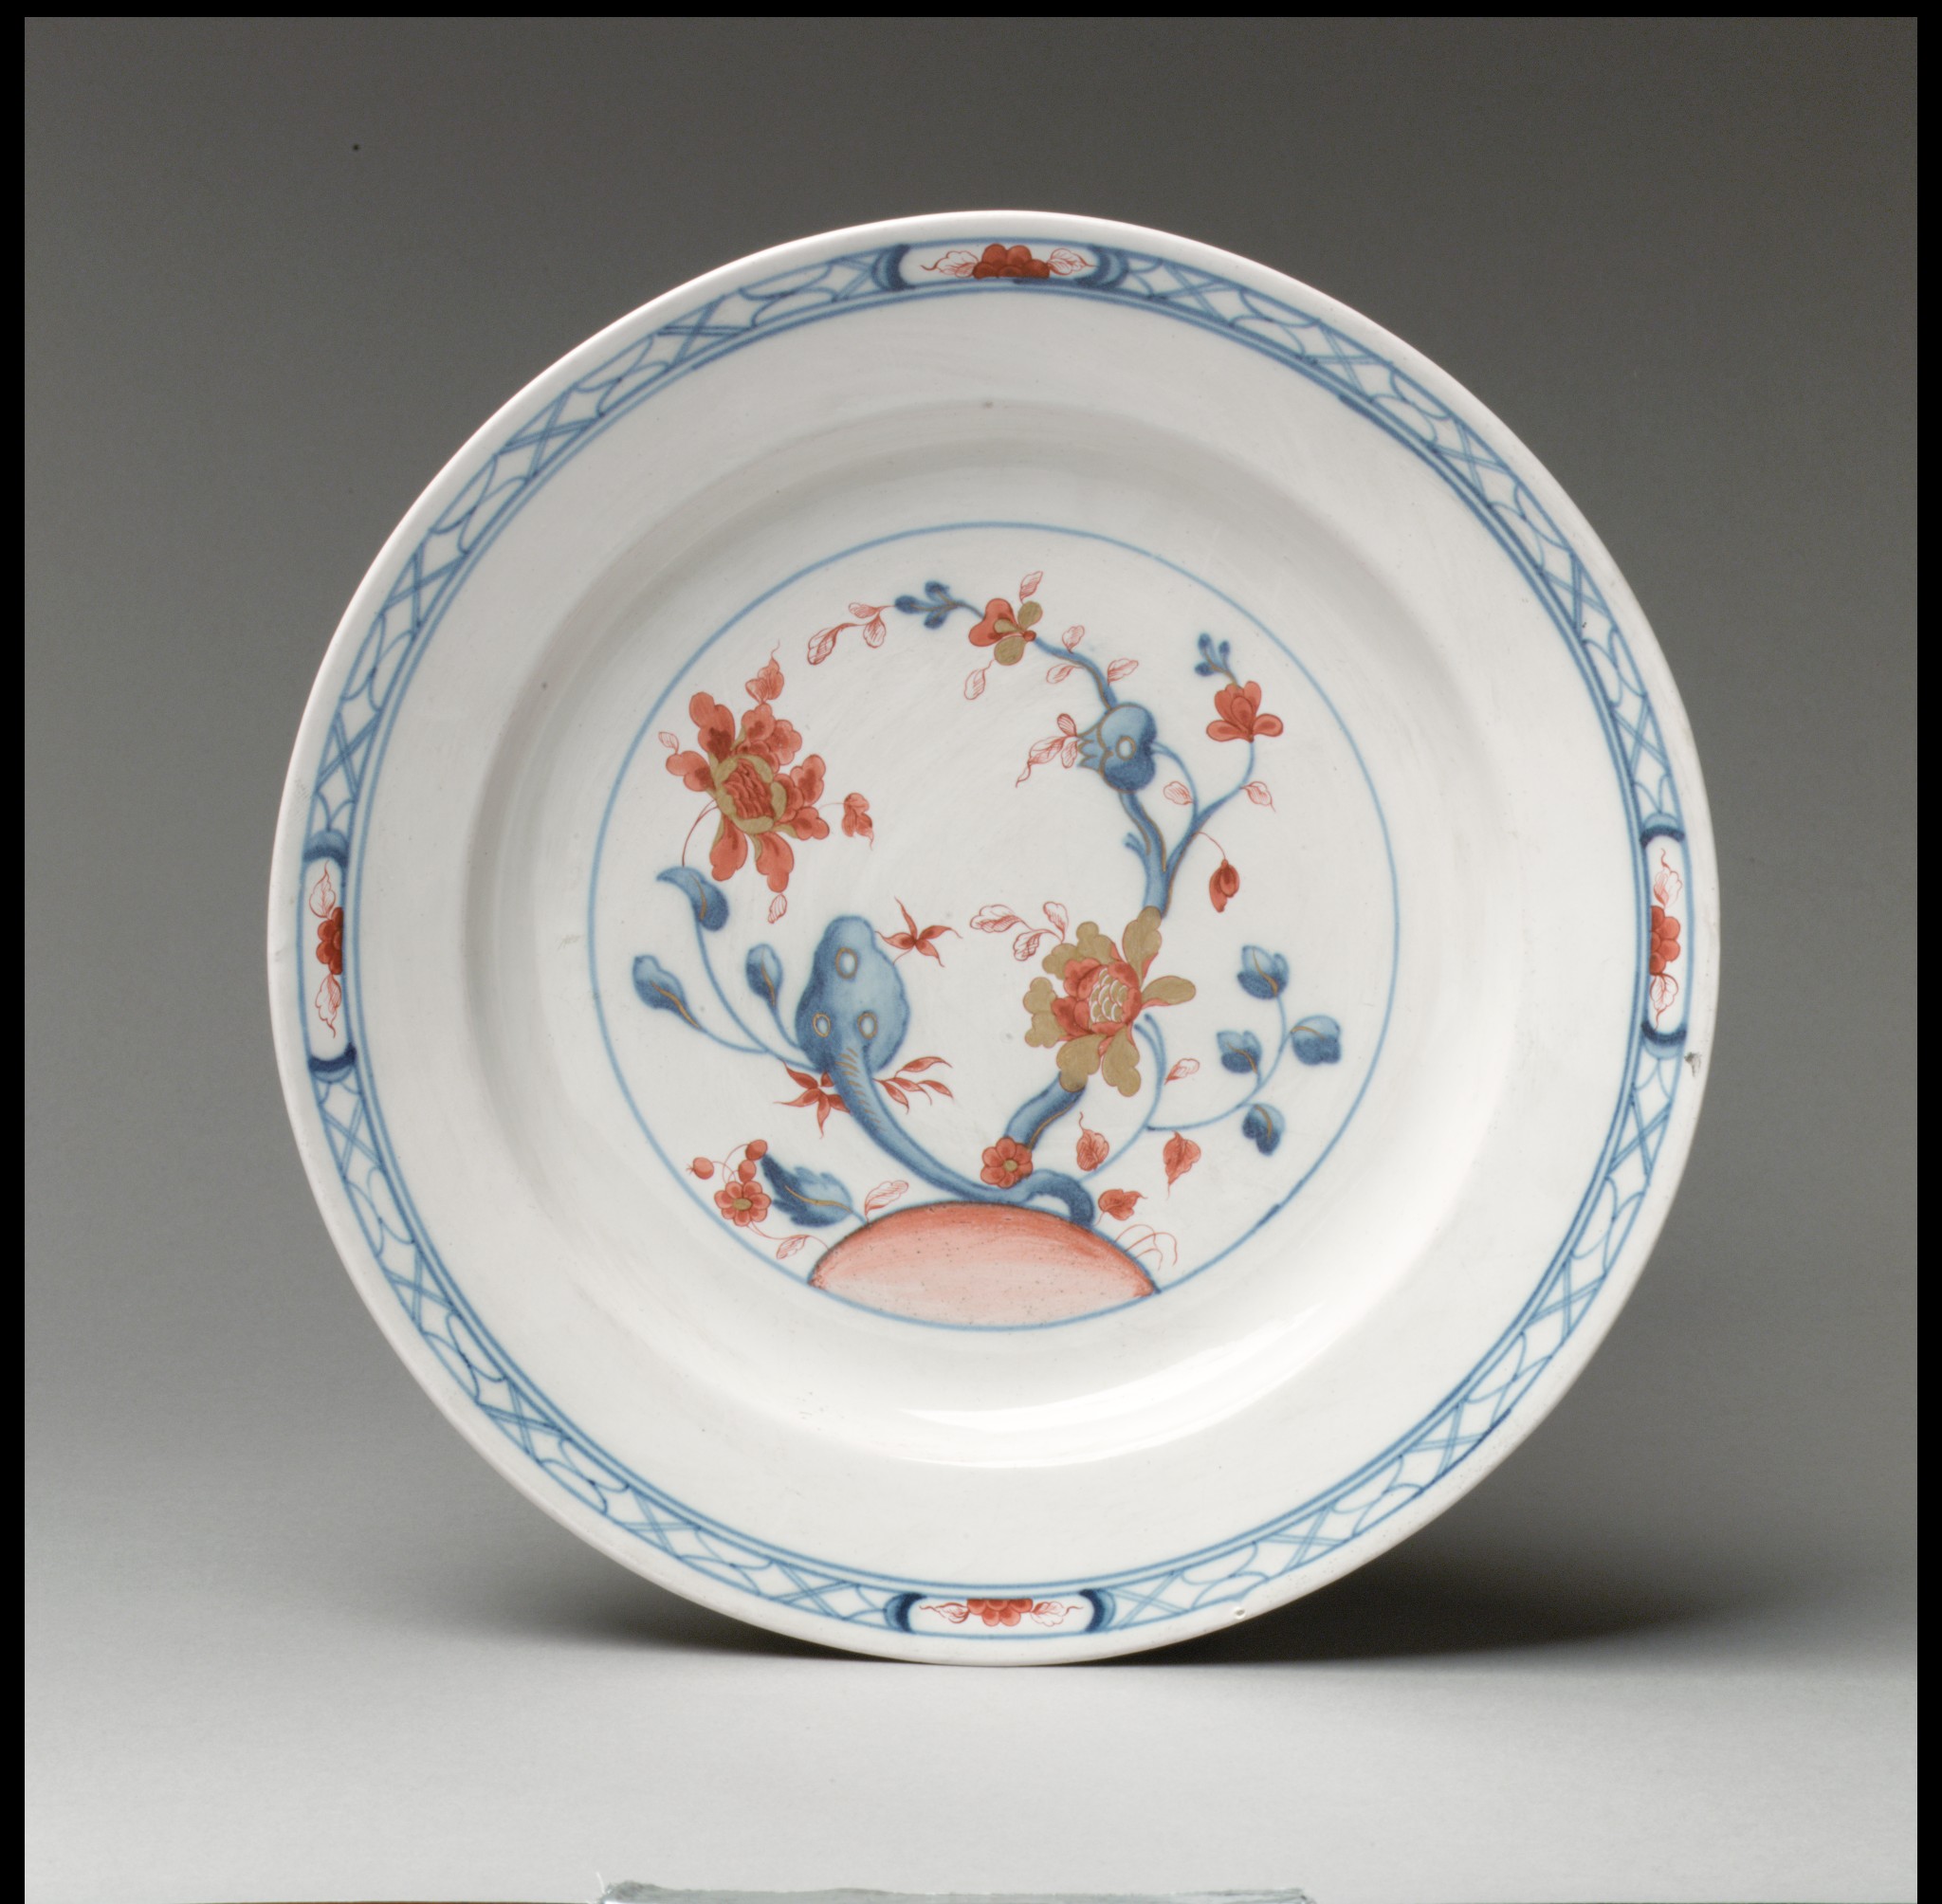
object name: plate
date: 1765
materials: earthenware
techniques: glazing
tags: flowers